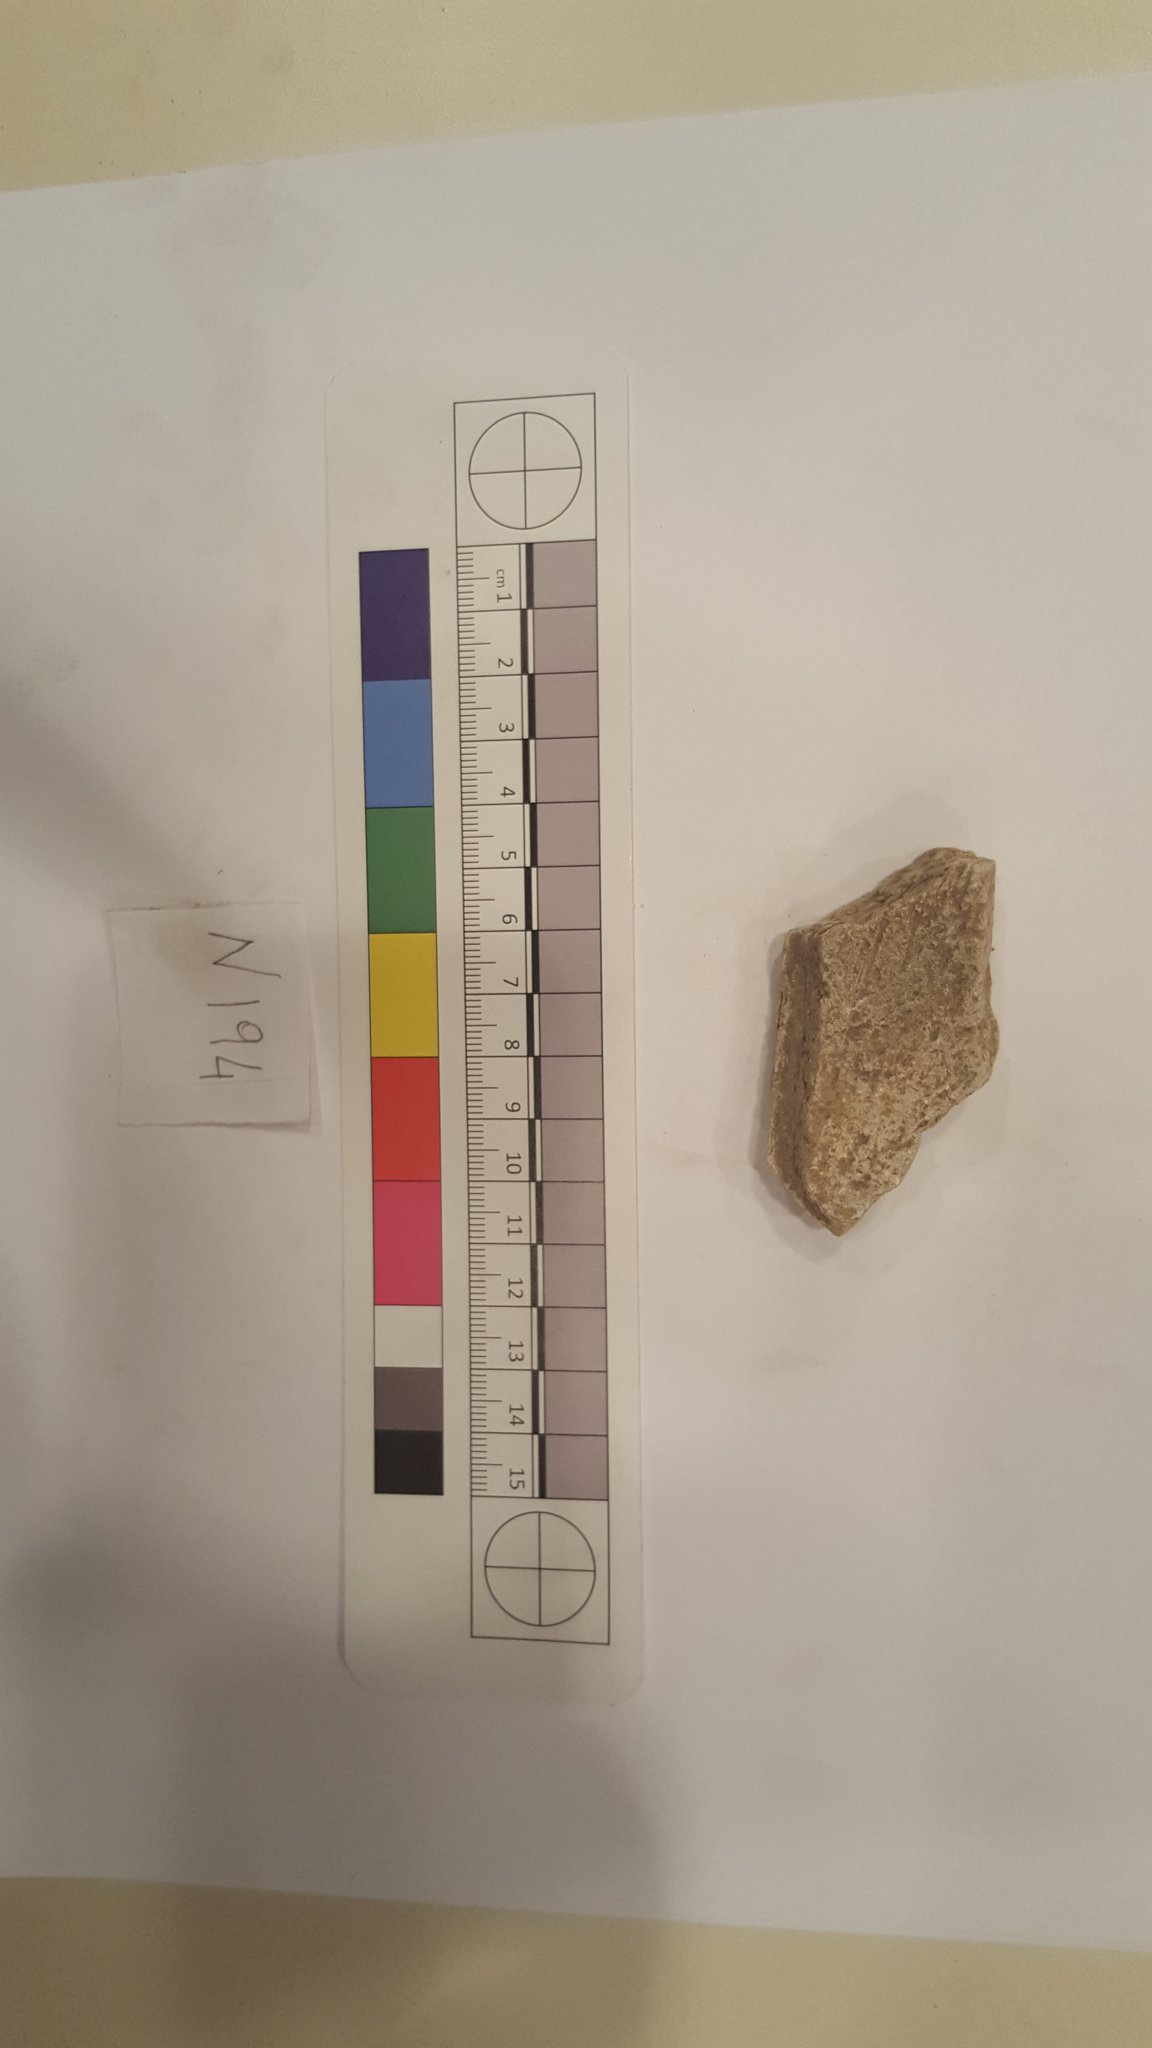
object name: fragment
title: Stucco Fragment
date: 701-1200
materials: plaster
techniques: carving, painting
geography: iran